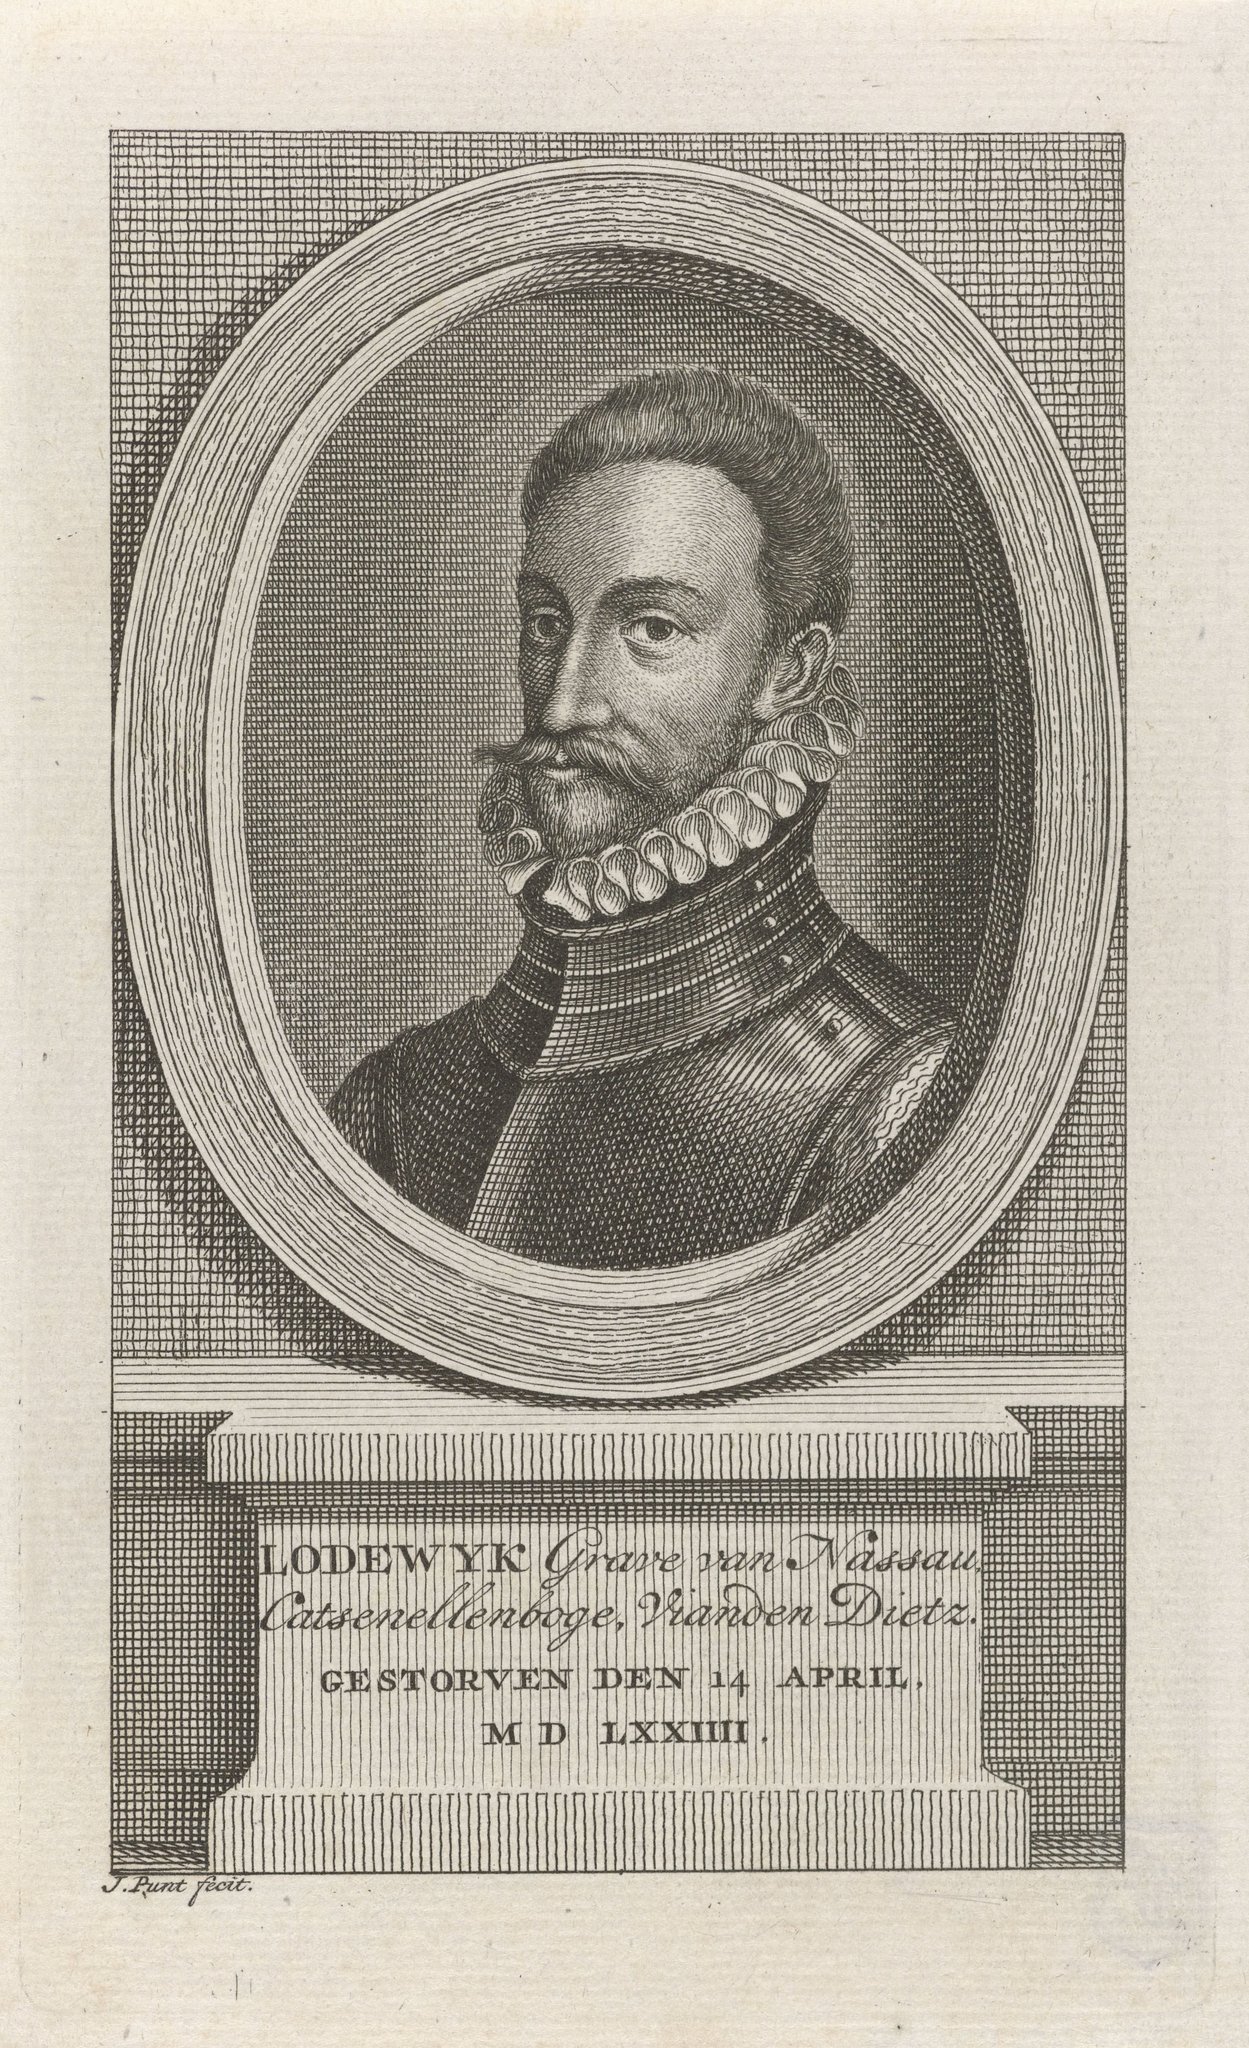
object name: print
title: Portret van Lodewijk, graaf van Nassau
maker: jan punt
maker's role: draughtsman, print maker, publisher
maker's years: 1711-1779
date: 1731-1779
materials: paper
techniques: engraving, etching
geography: northern netherlands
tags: dillenburg, lodewijk graaf van nassau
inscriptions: collector's mark: Lugt 963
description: De hier vermelde titel verwijst naar de hoogst verkregen titel van de geportretteerde, niet per se naar de titel die de geportretteerde op deze voorstelling draagt.